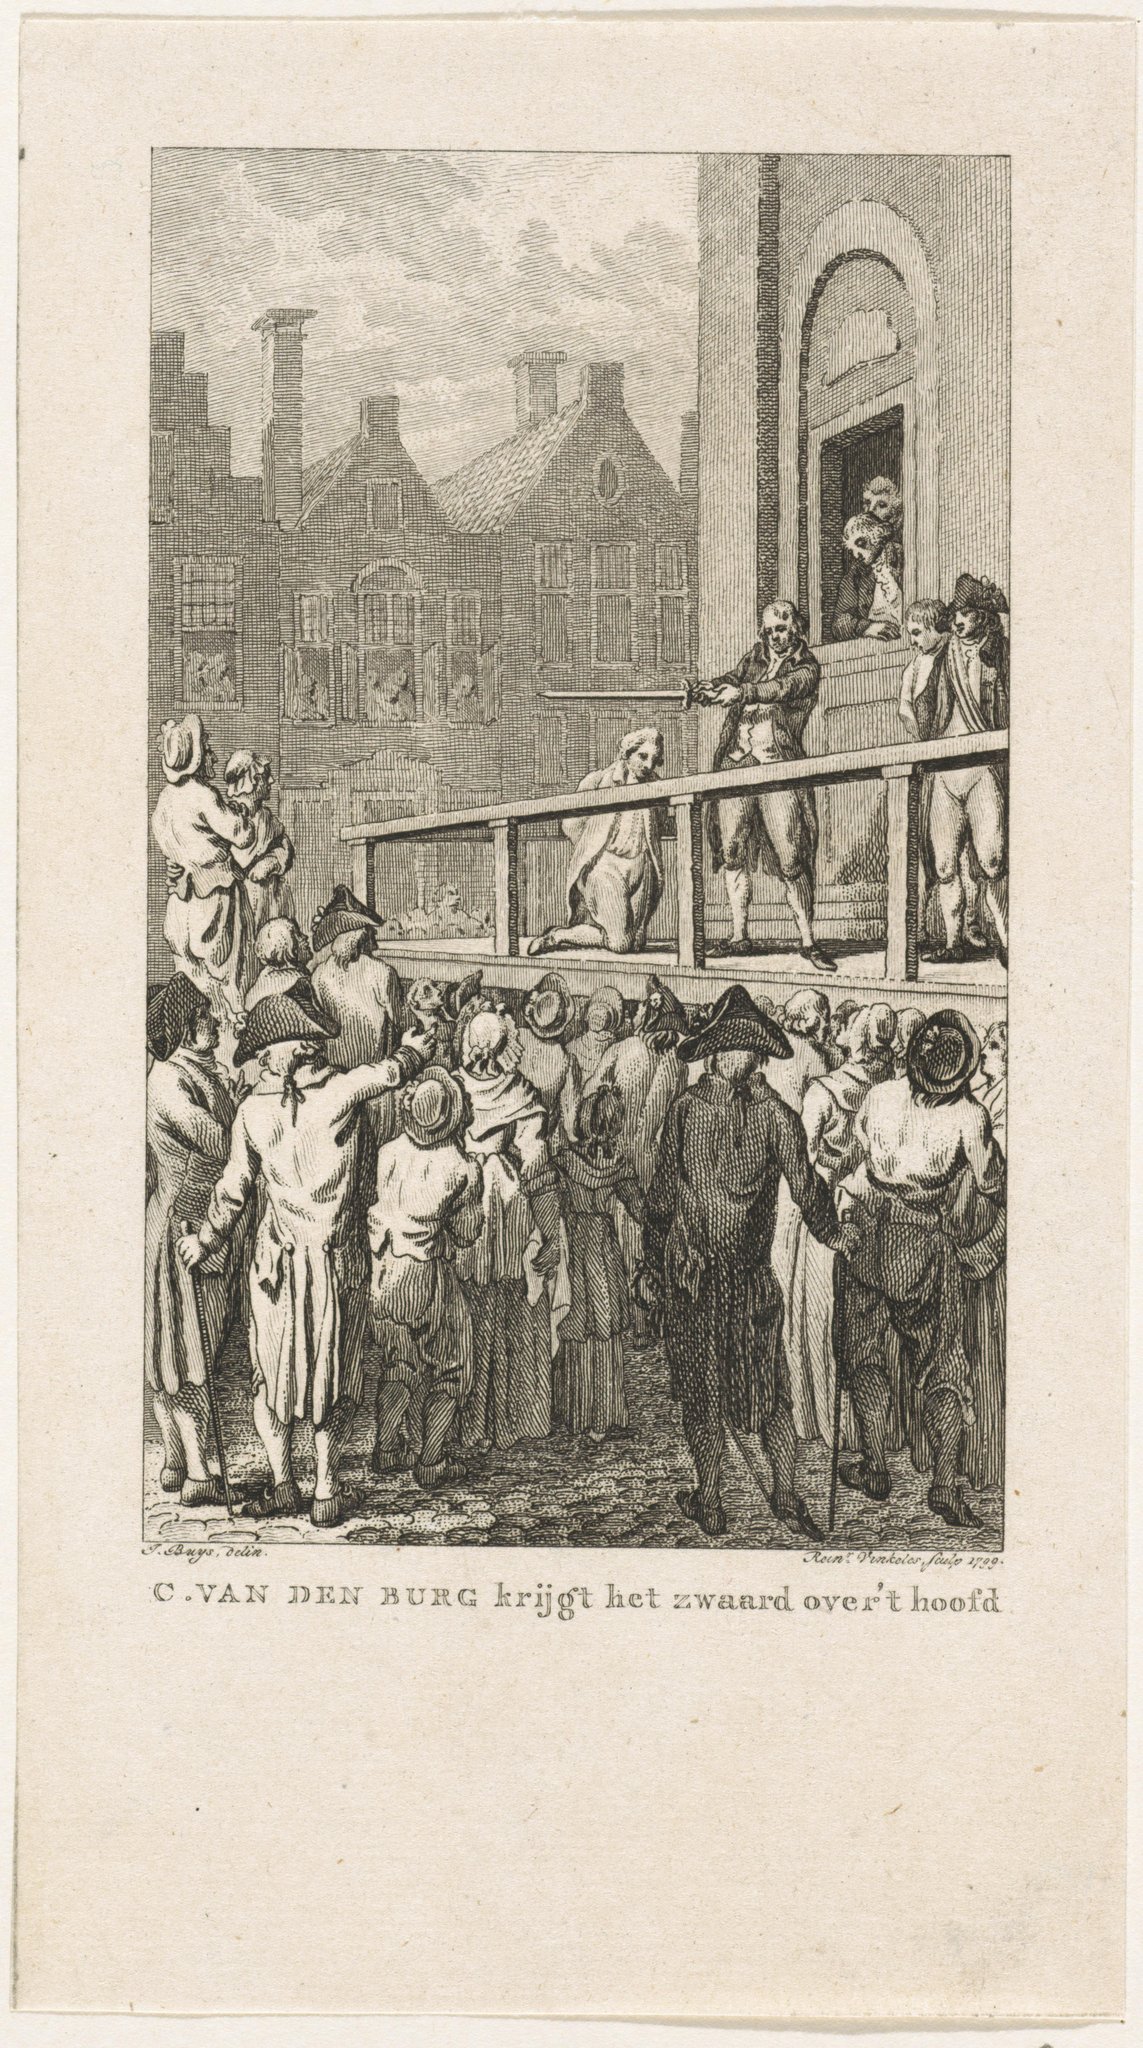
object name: print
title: C. van den Burg krijgt het zwaard over 't hoofd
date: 1799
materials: paper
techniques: engraving, etching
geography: northern netherlands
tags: mayor, pardon, reprieve, violent death by hanging, patriots (1780-1795)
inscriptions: collector's mark: Lugt 2228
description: Terechtstelling van Cornelis van der Burg, uitgesproken patriotse burgemeester van Bolsward, te Leeuwarden op 16 mei 1789. Als de burgemeester knielt op het schavot houdt de beul het zwaard boven zijn hoofd en wordt het doodsvonnis omgezet in een verbanning van twintig jaar.